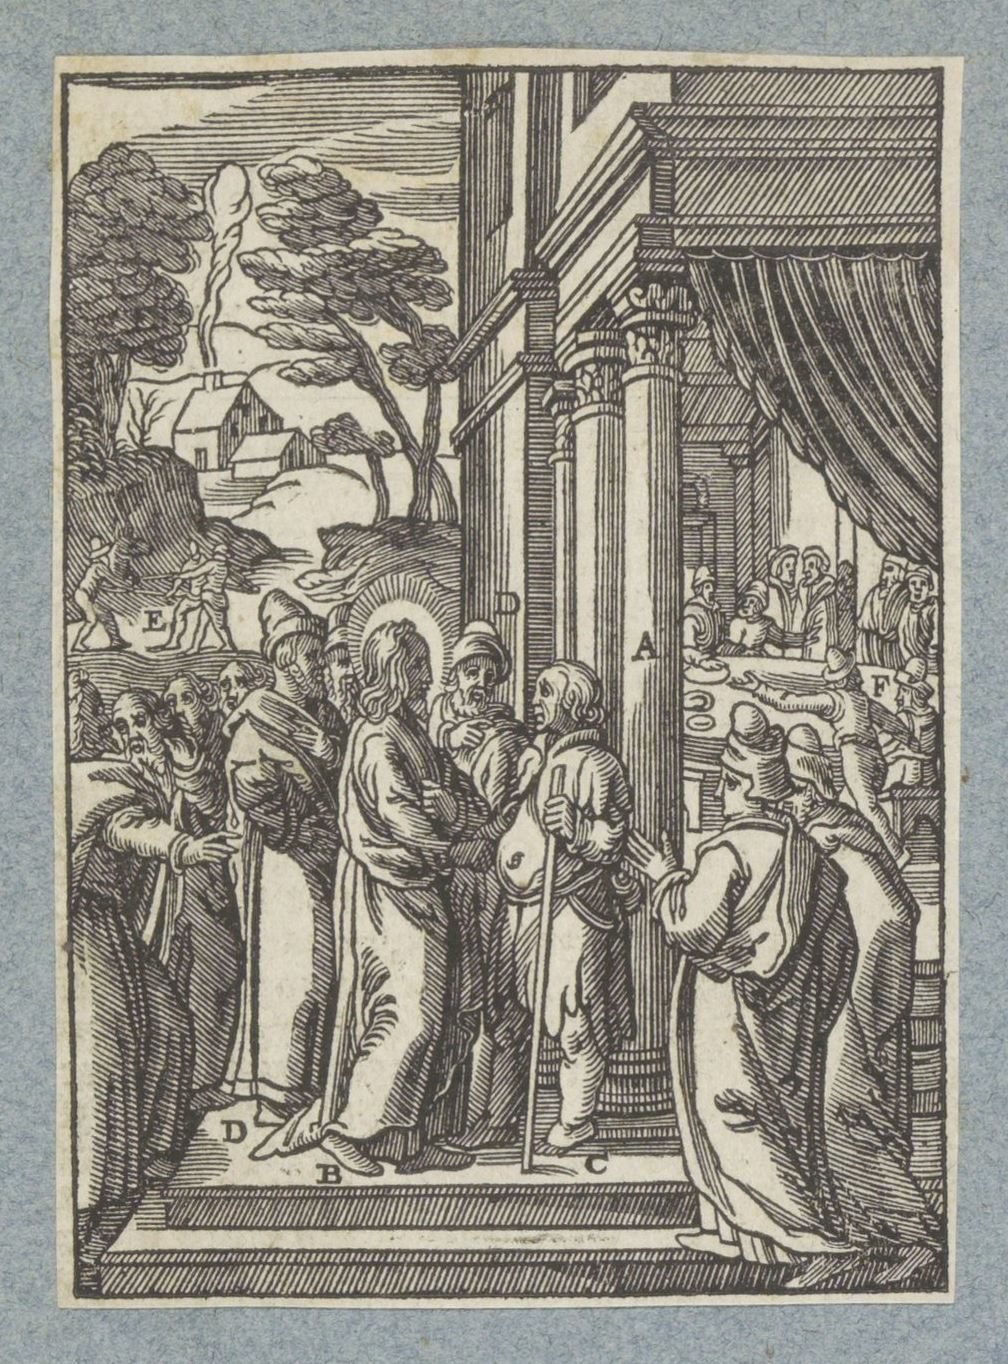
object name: book illustration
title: Christus geneest een man met waterzucht op sabbat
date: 1629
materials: paper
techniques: letterpress printing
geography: amsterdam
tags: healing of a man with dropsy (luke 14:2-4)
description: De prent is afkomstig uit een van de uitgaven van P.J. Paets uit Amsterdam. De prent wordt voor het eerst gebruikt in: Der Zielen Lust-hof. Leuven, I.Jacbosz voor P.J. Paets [= Amsterdam, P.J. Paets], 1629. De voorstelling is gekopieerd naar een prent van Antonie II Wierix voor: Nadal, Jerónimo. Evangelicae Historiae Imagines. Antwerpen, M. Nutius, 1593.